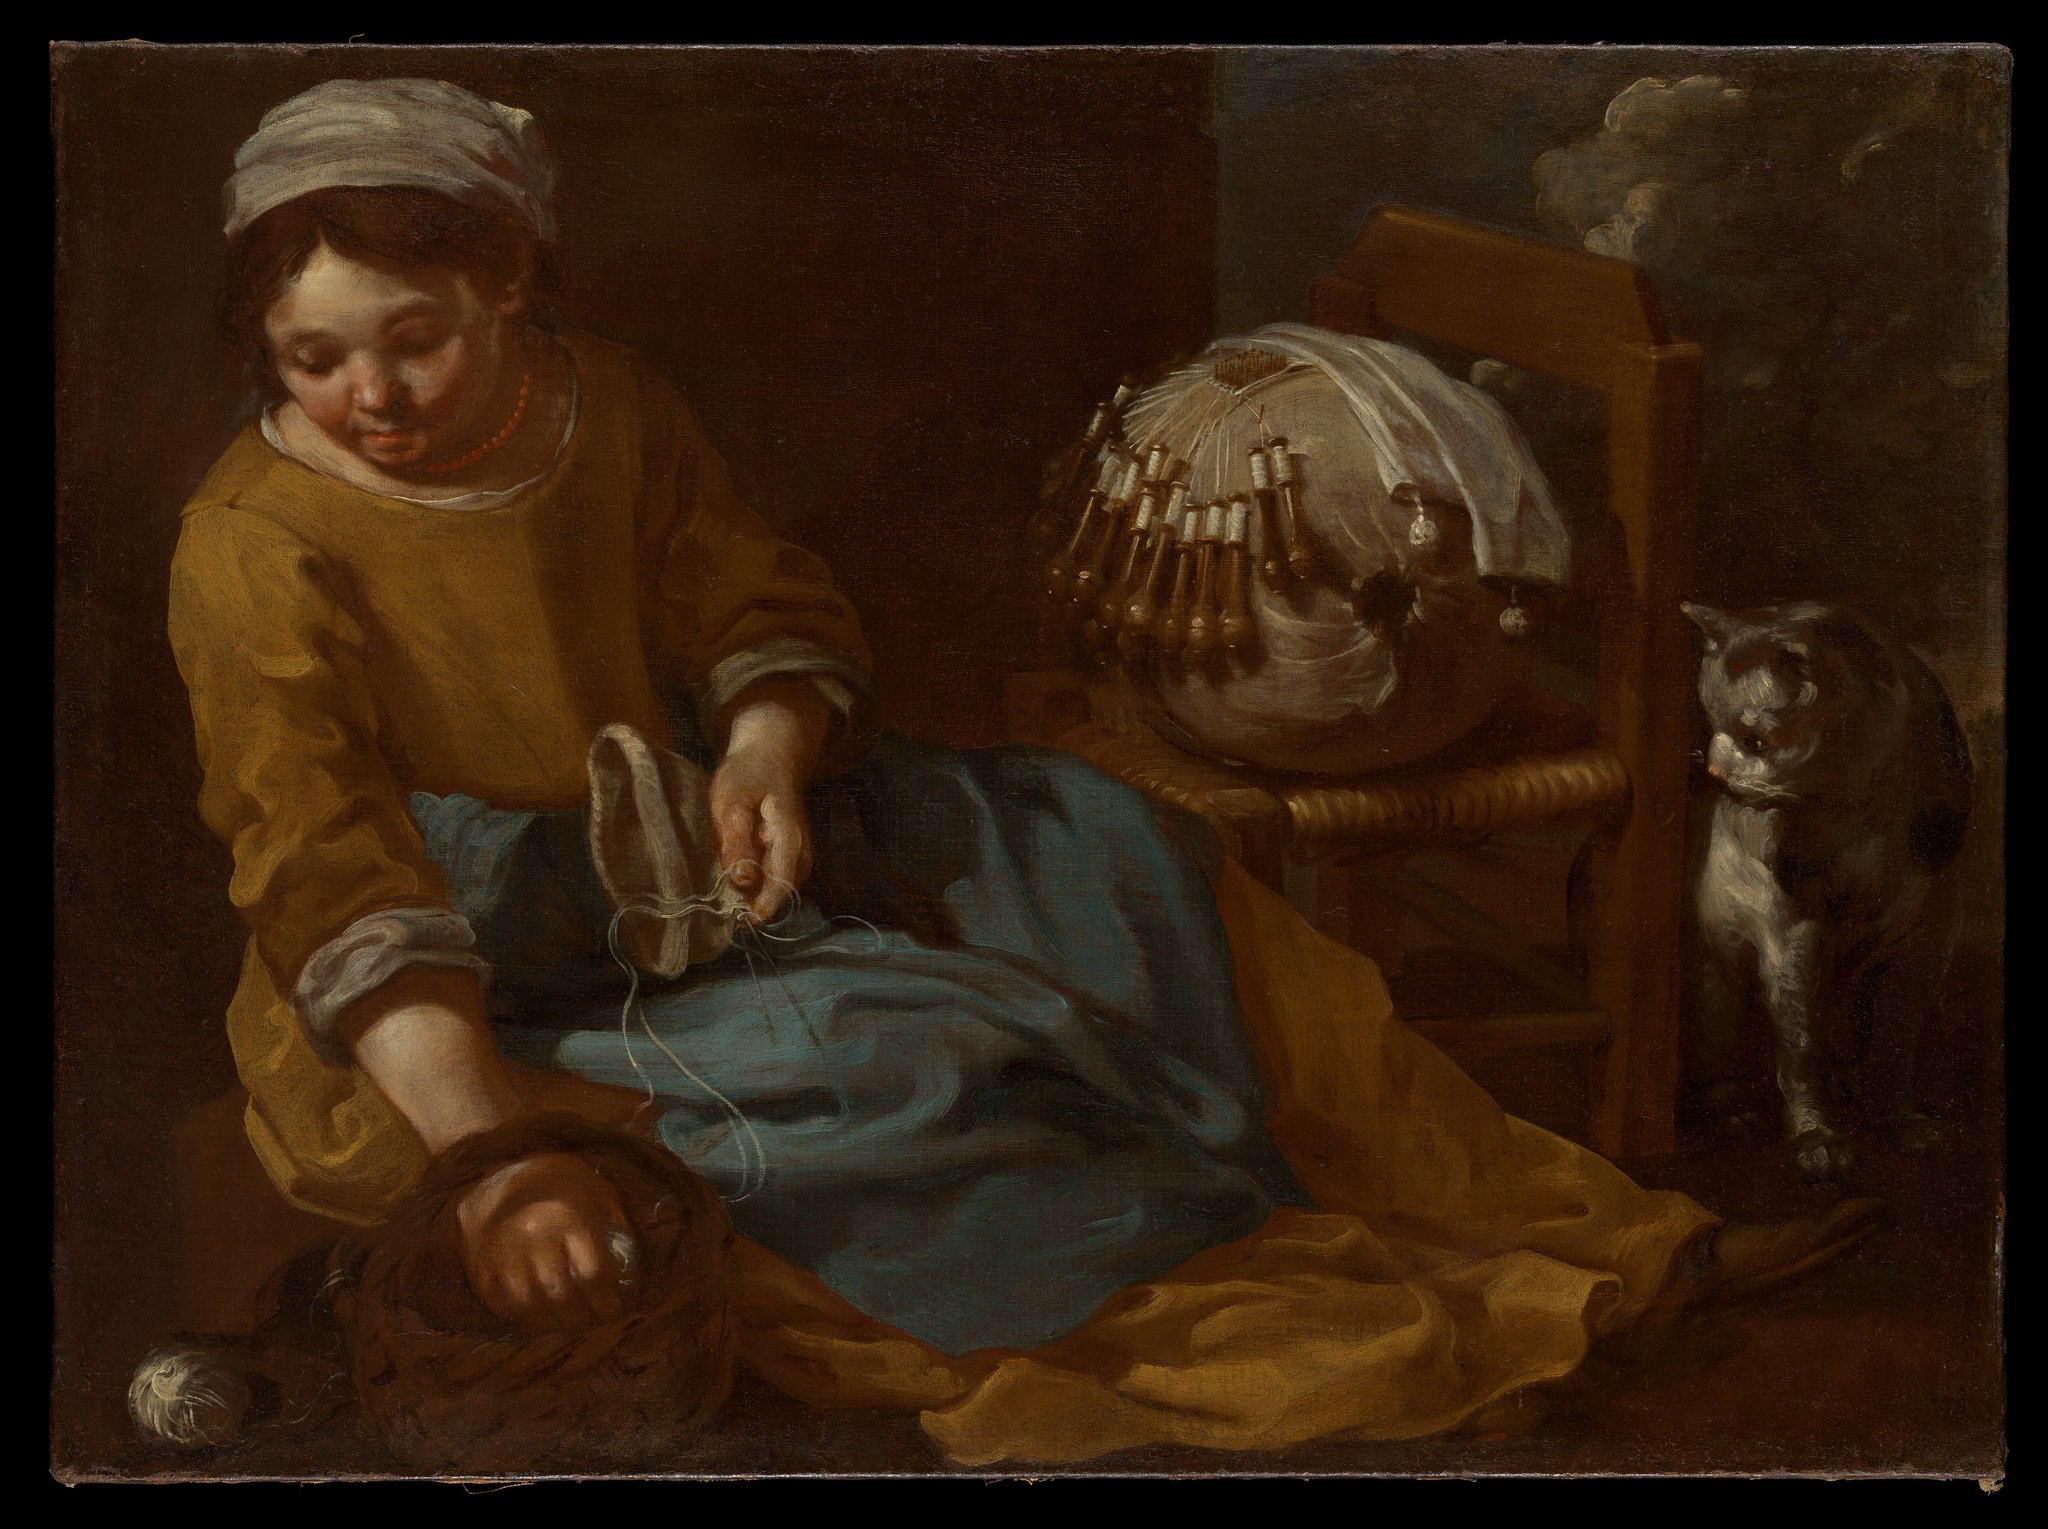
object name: painting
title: The Lacemaker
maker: bernhard keil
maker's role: artist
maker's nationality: danish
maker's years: 1624-1687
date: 1665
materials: canvas, oil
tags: women,cats,needlework